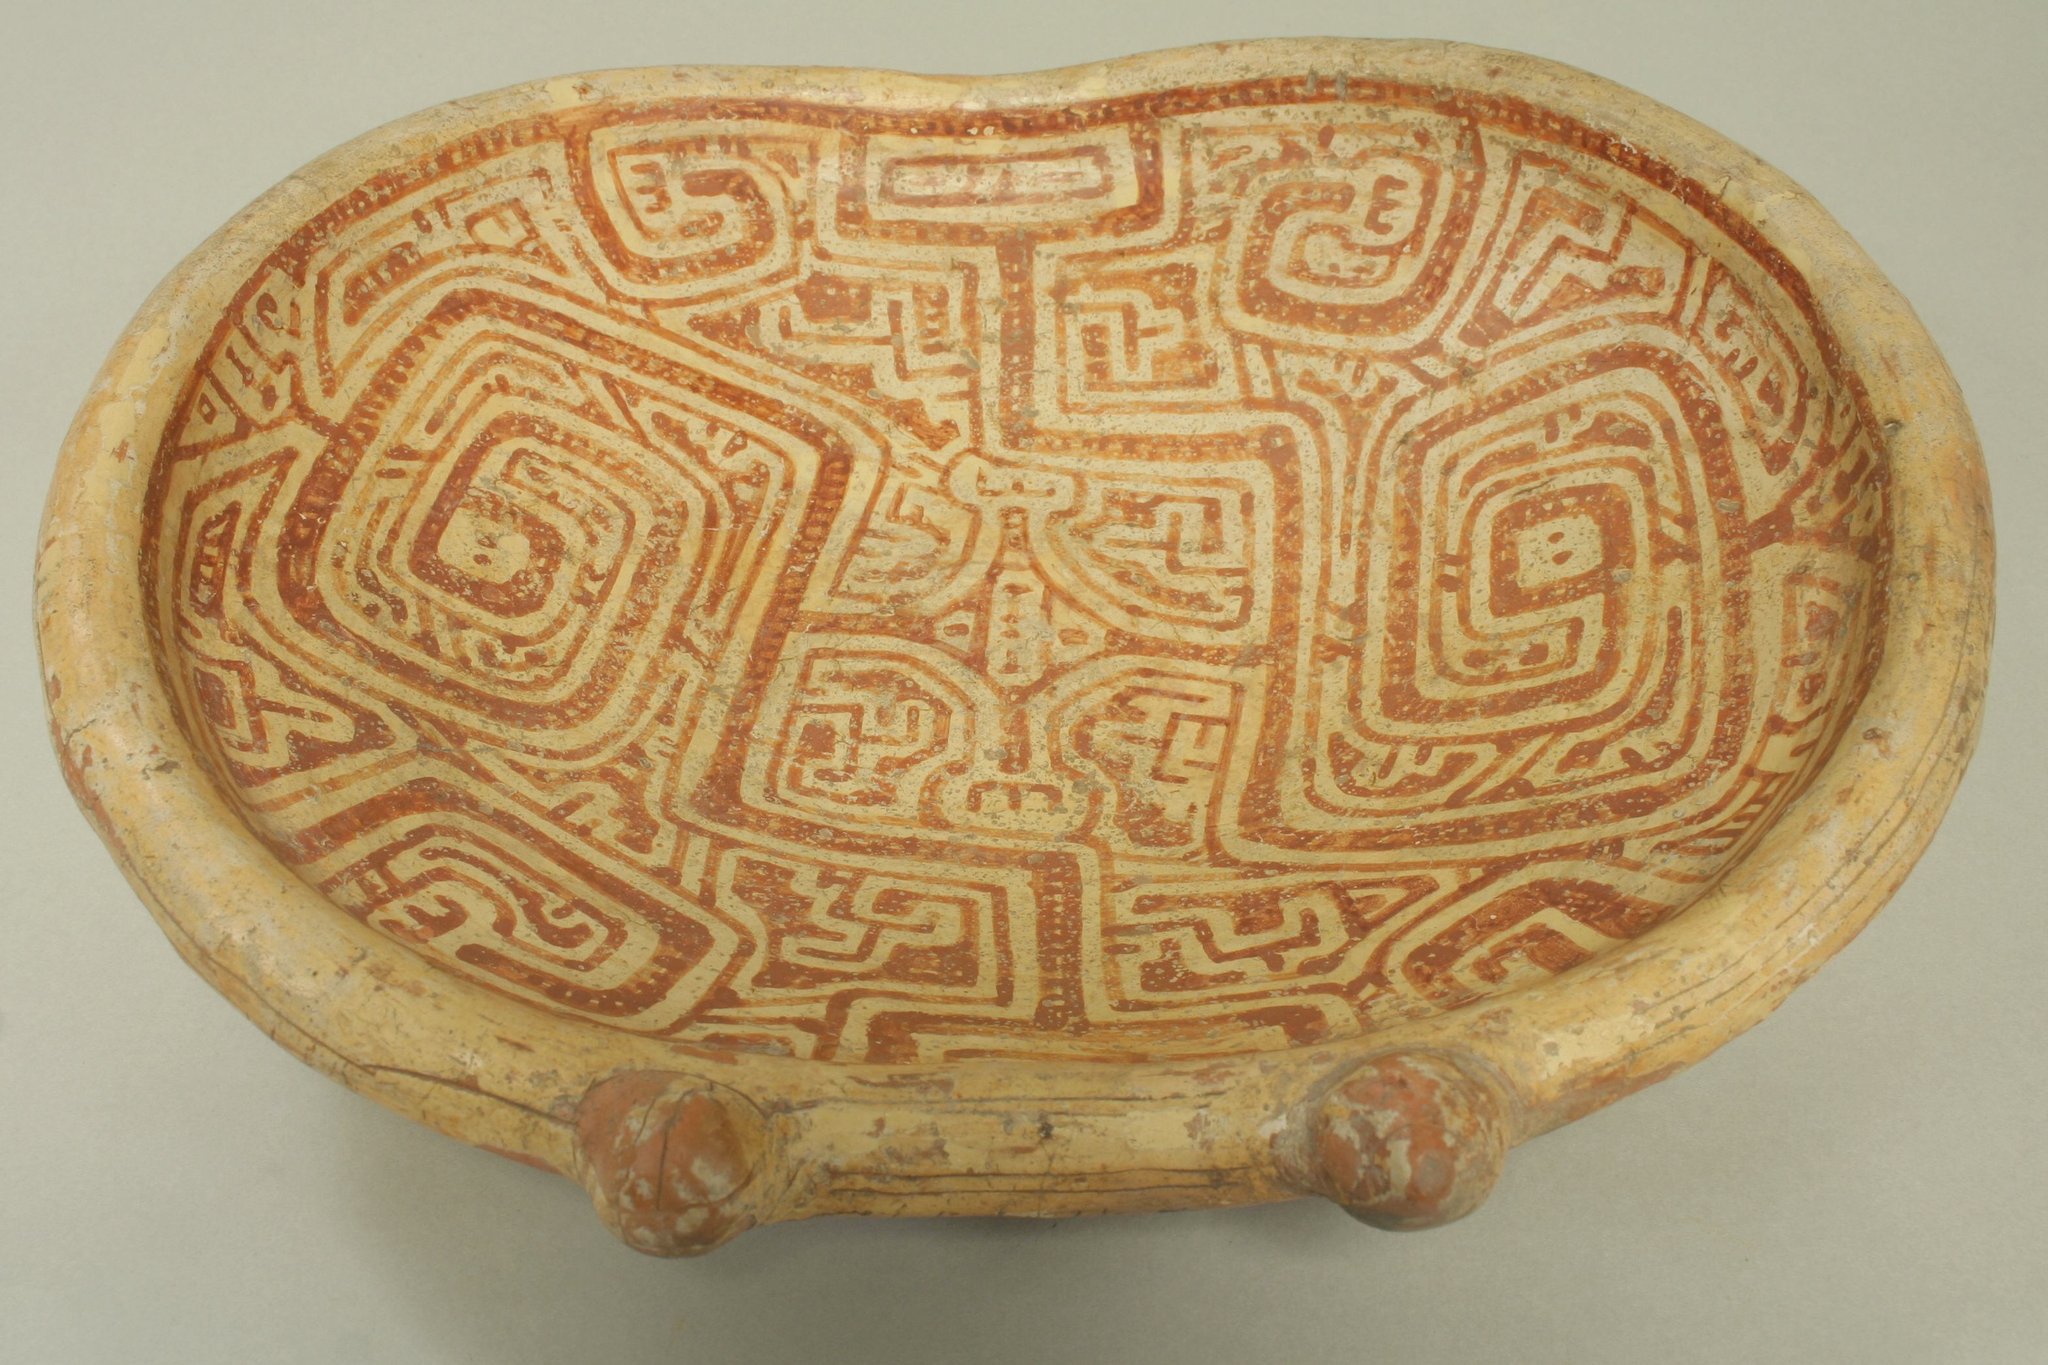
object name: plate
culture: marajo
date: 701-1200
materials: ceramic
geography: brazil